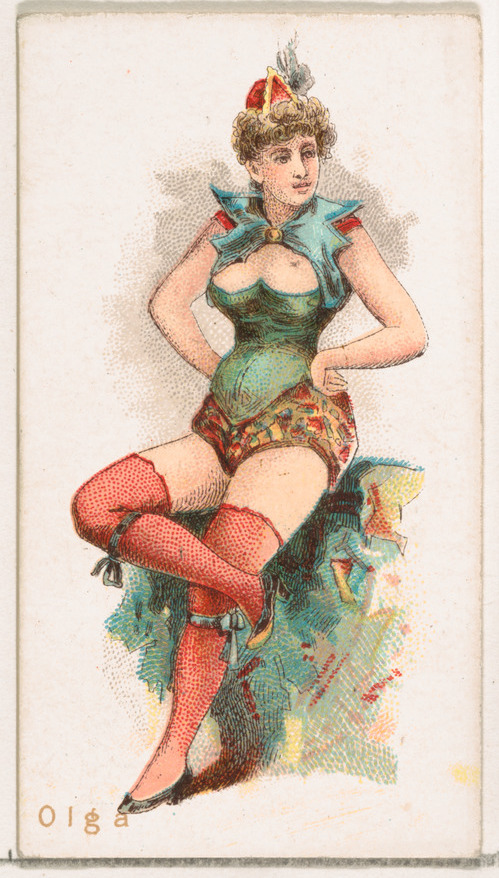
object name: print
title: Olga, from the Ballet Queens series (N182) issued by Wm. S. Kimball & Co.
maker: william s. kimball & company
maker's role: publisher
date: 1889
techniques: color lithograph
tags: women,dancers